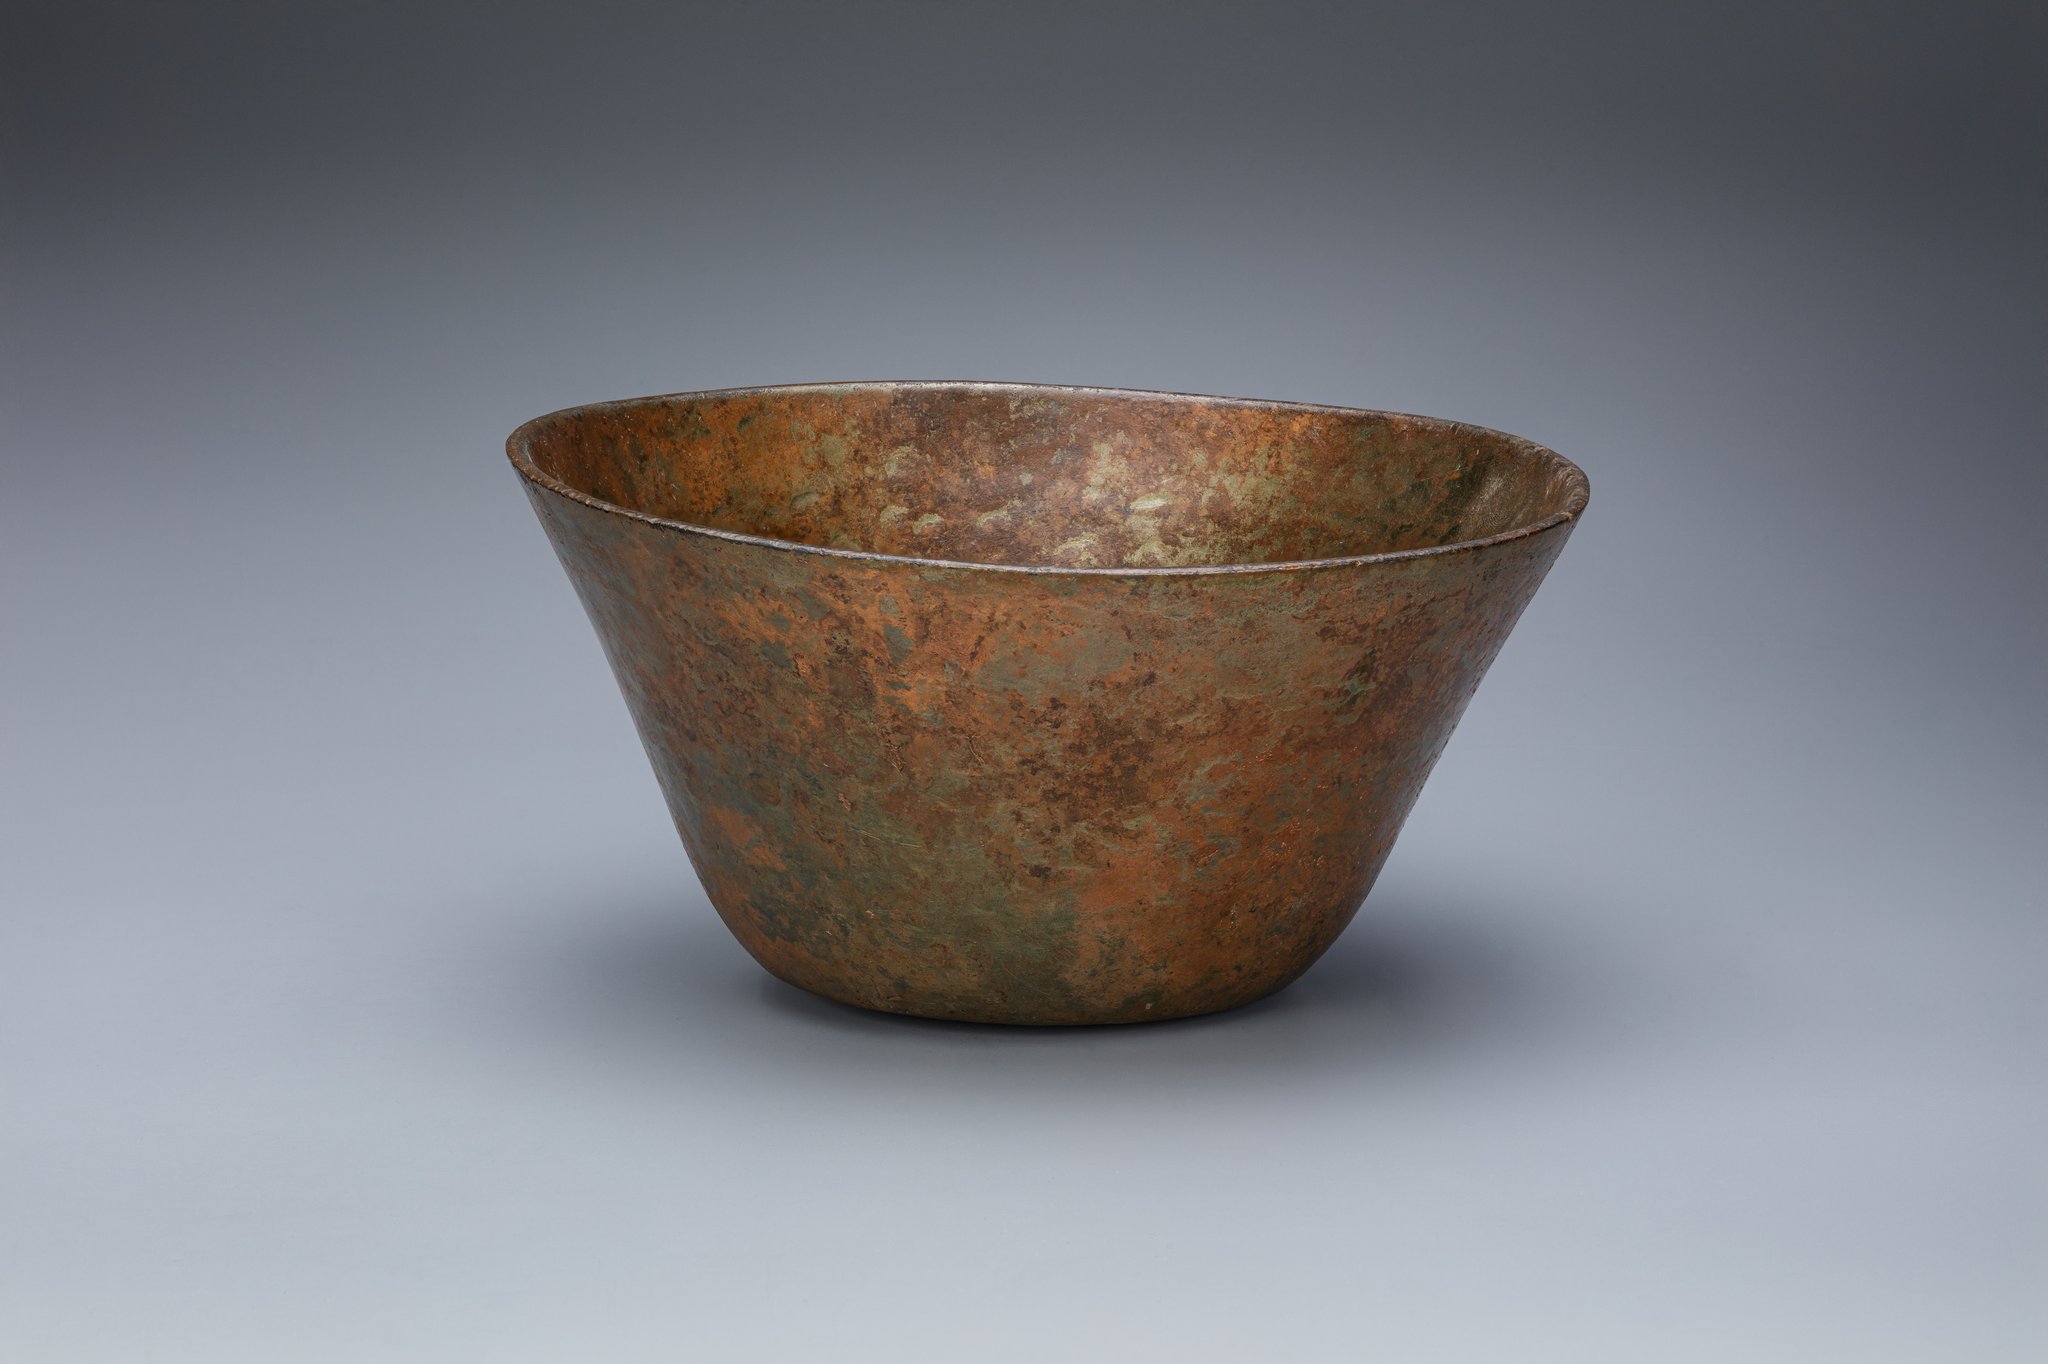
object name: basin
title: Basin, from basin and ewer set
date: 2465-2323 BCE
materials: copper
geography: egypt